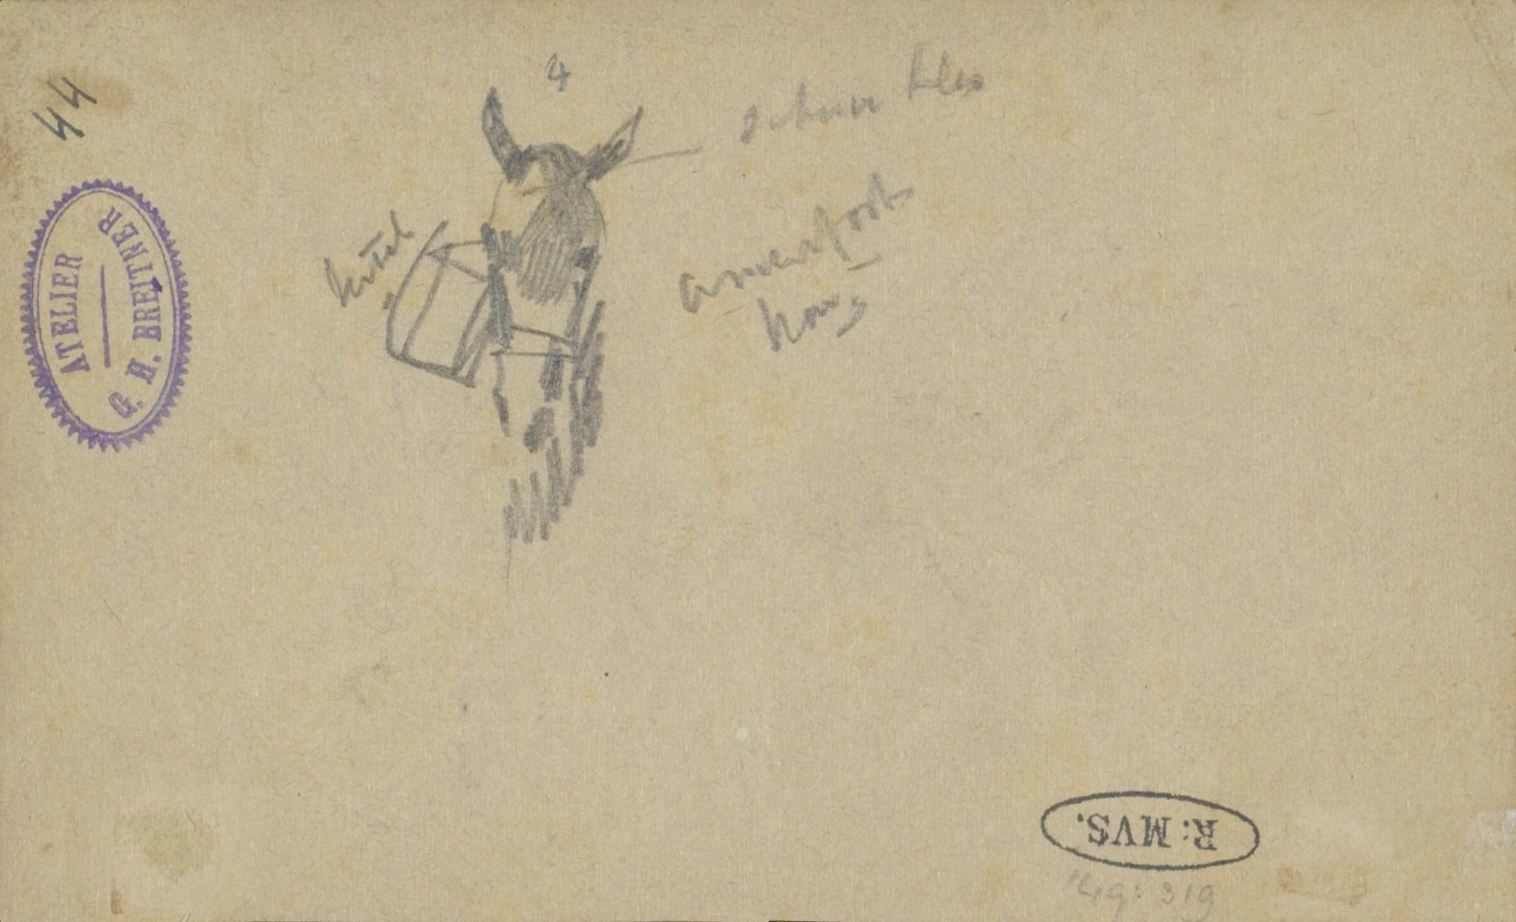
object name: drawing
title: Paardenhoofd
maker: george hendrik breitner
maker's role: draughtsman, painter, print maker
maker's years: 1857-1923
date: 1887-1912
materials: paper, pencil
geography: gelderland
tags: horse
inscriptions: annotation: ‘Amersfoort/ [...]’, workshop stamp: Lugt 291d, collector's mark: Lugt 2228, :